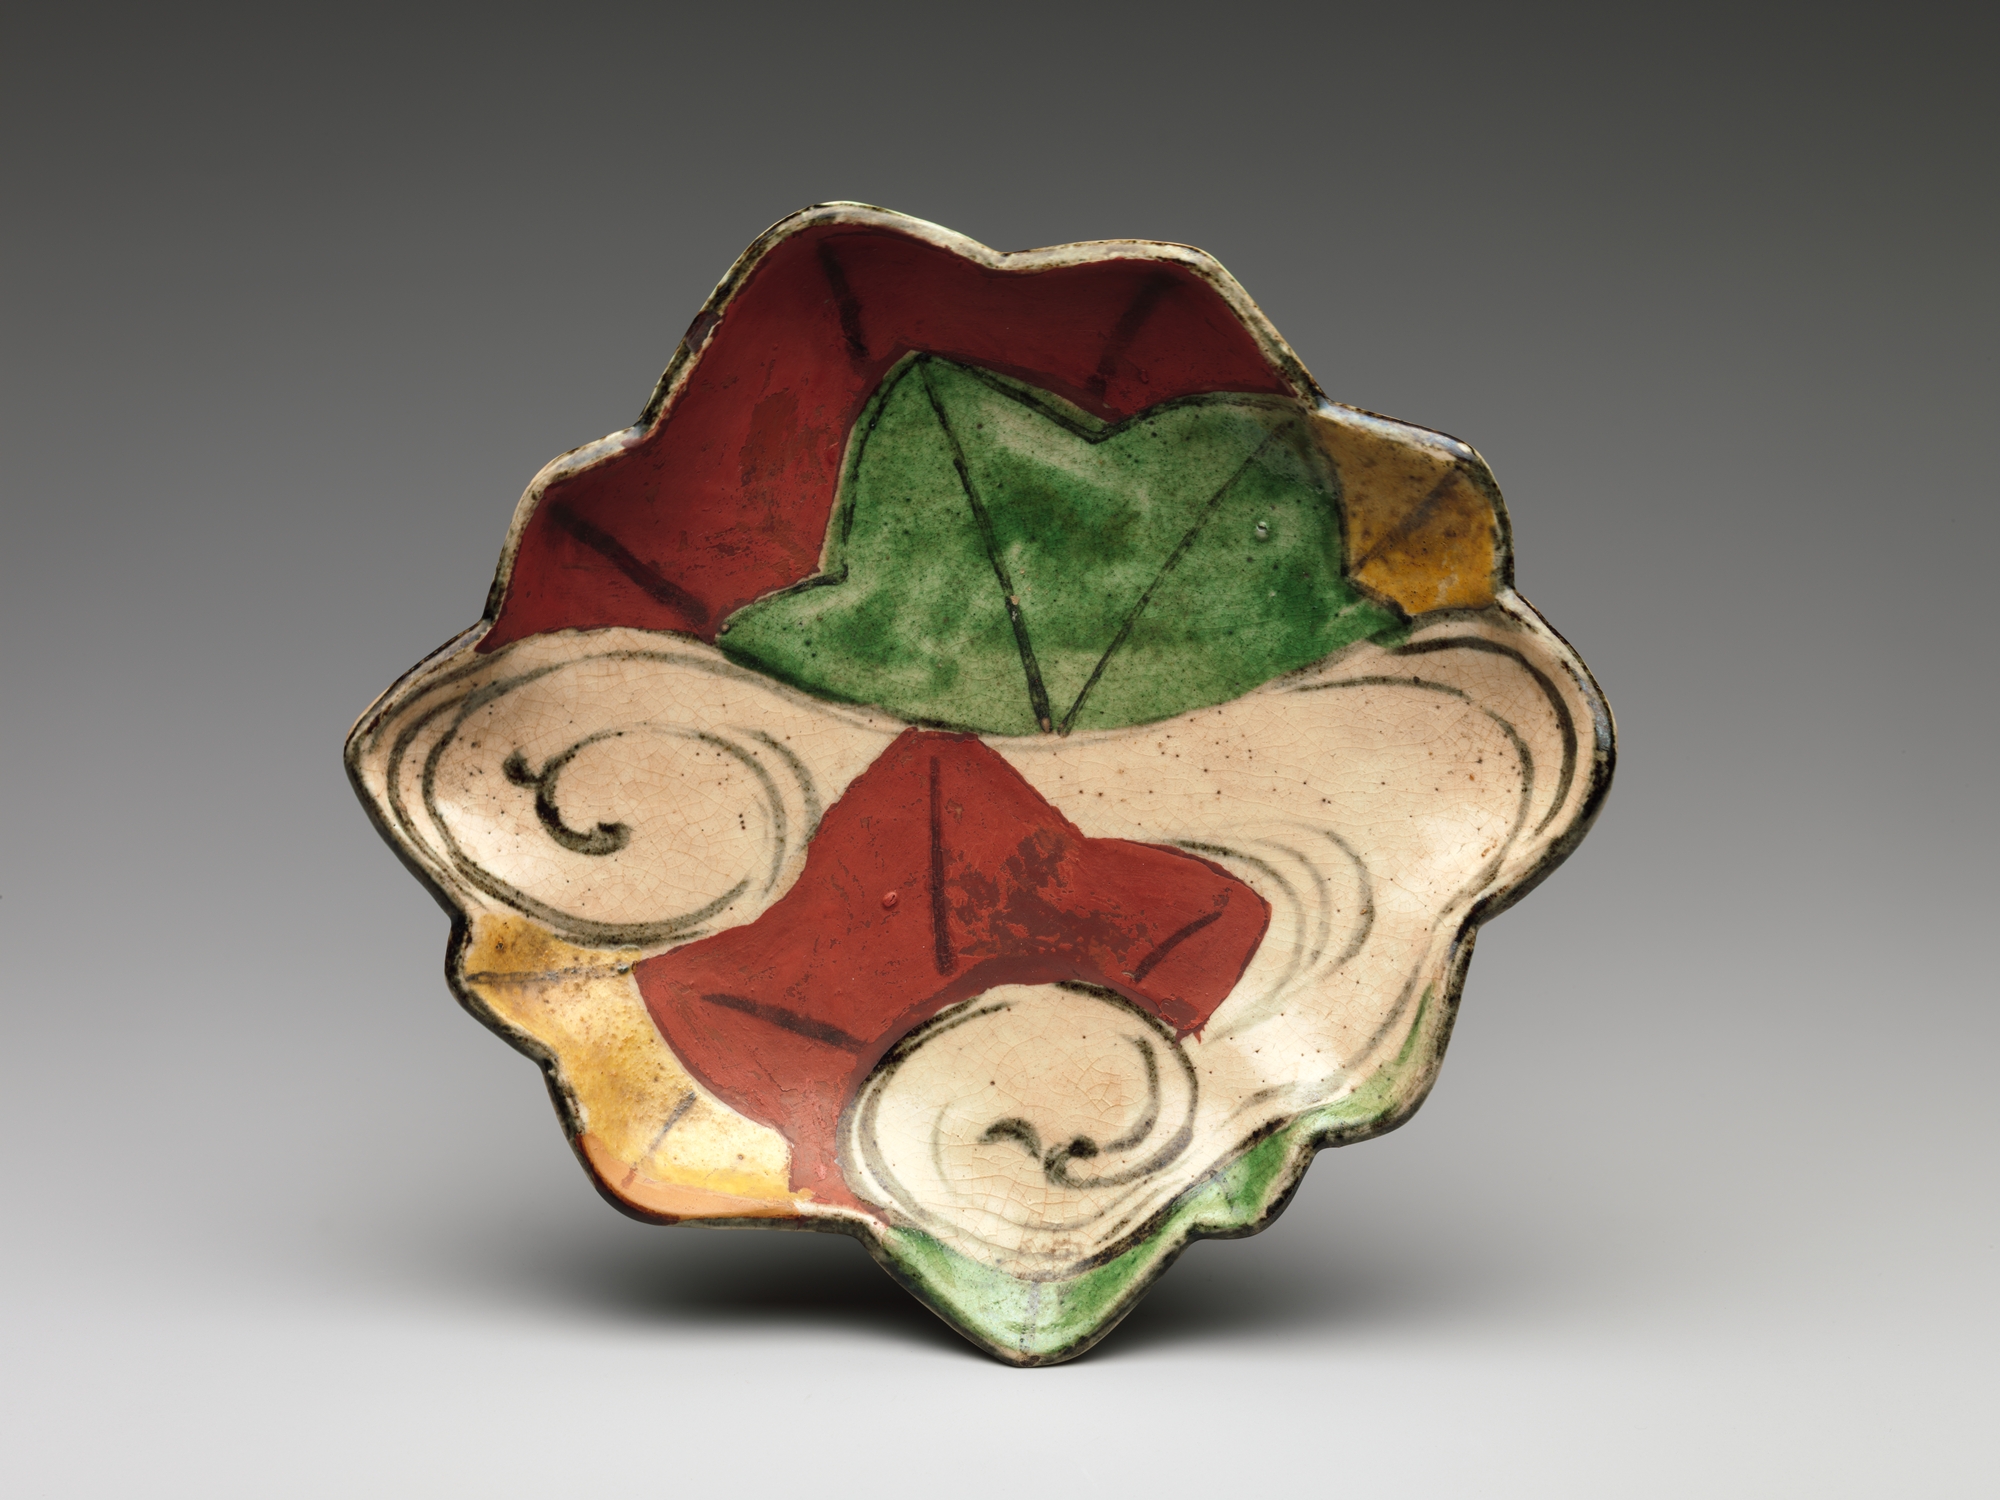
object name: dish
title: Dish with Design of Maple Leaves in a Stream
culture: japanese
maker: ogata kenzan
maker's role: artist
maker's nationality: japanese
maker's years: 1663-1743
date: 1801-1900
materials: enamel, stoneware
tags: leaves